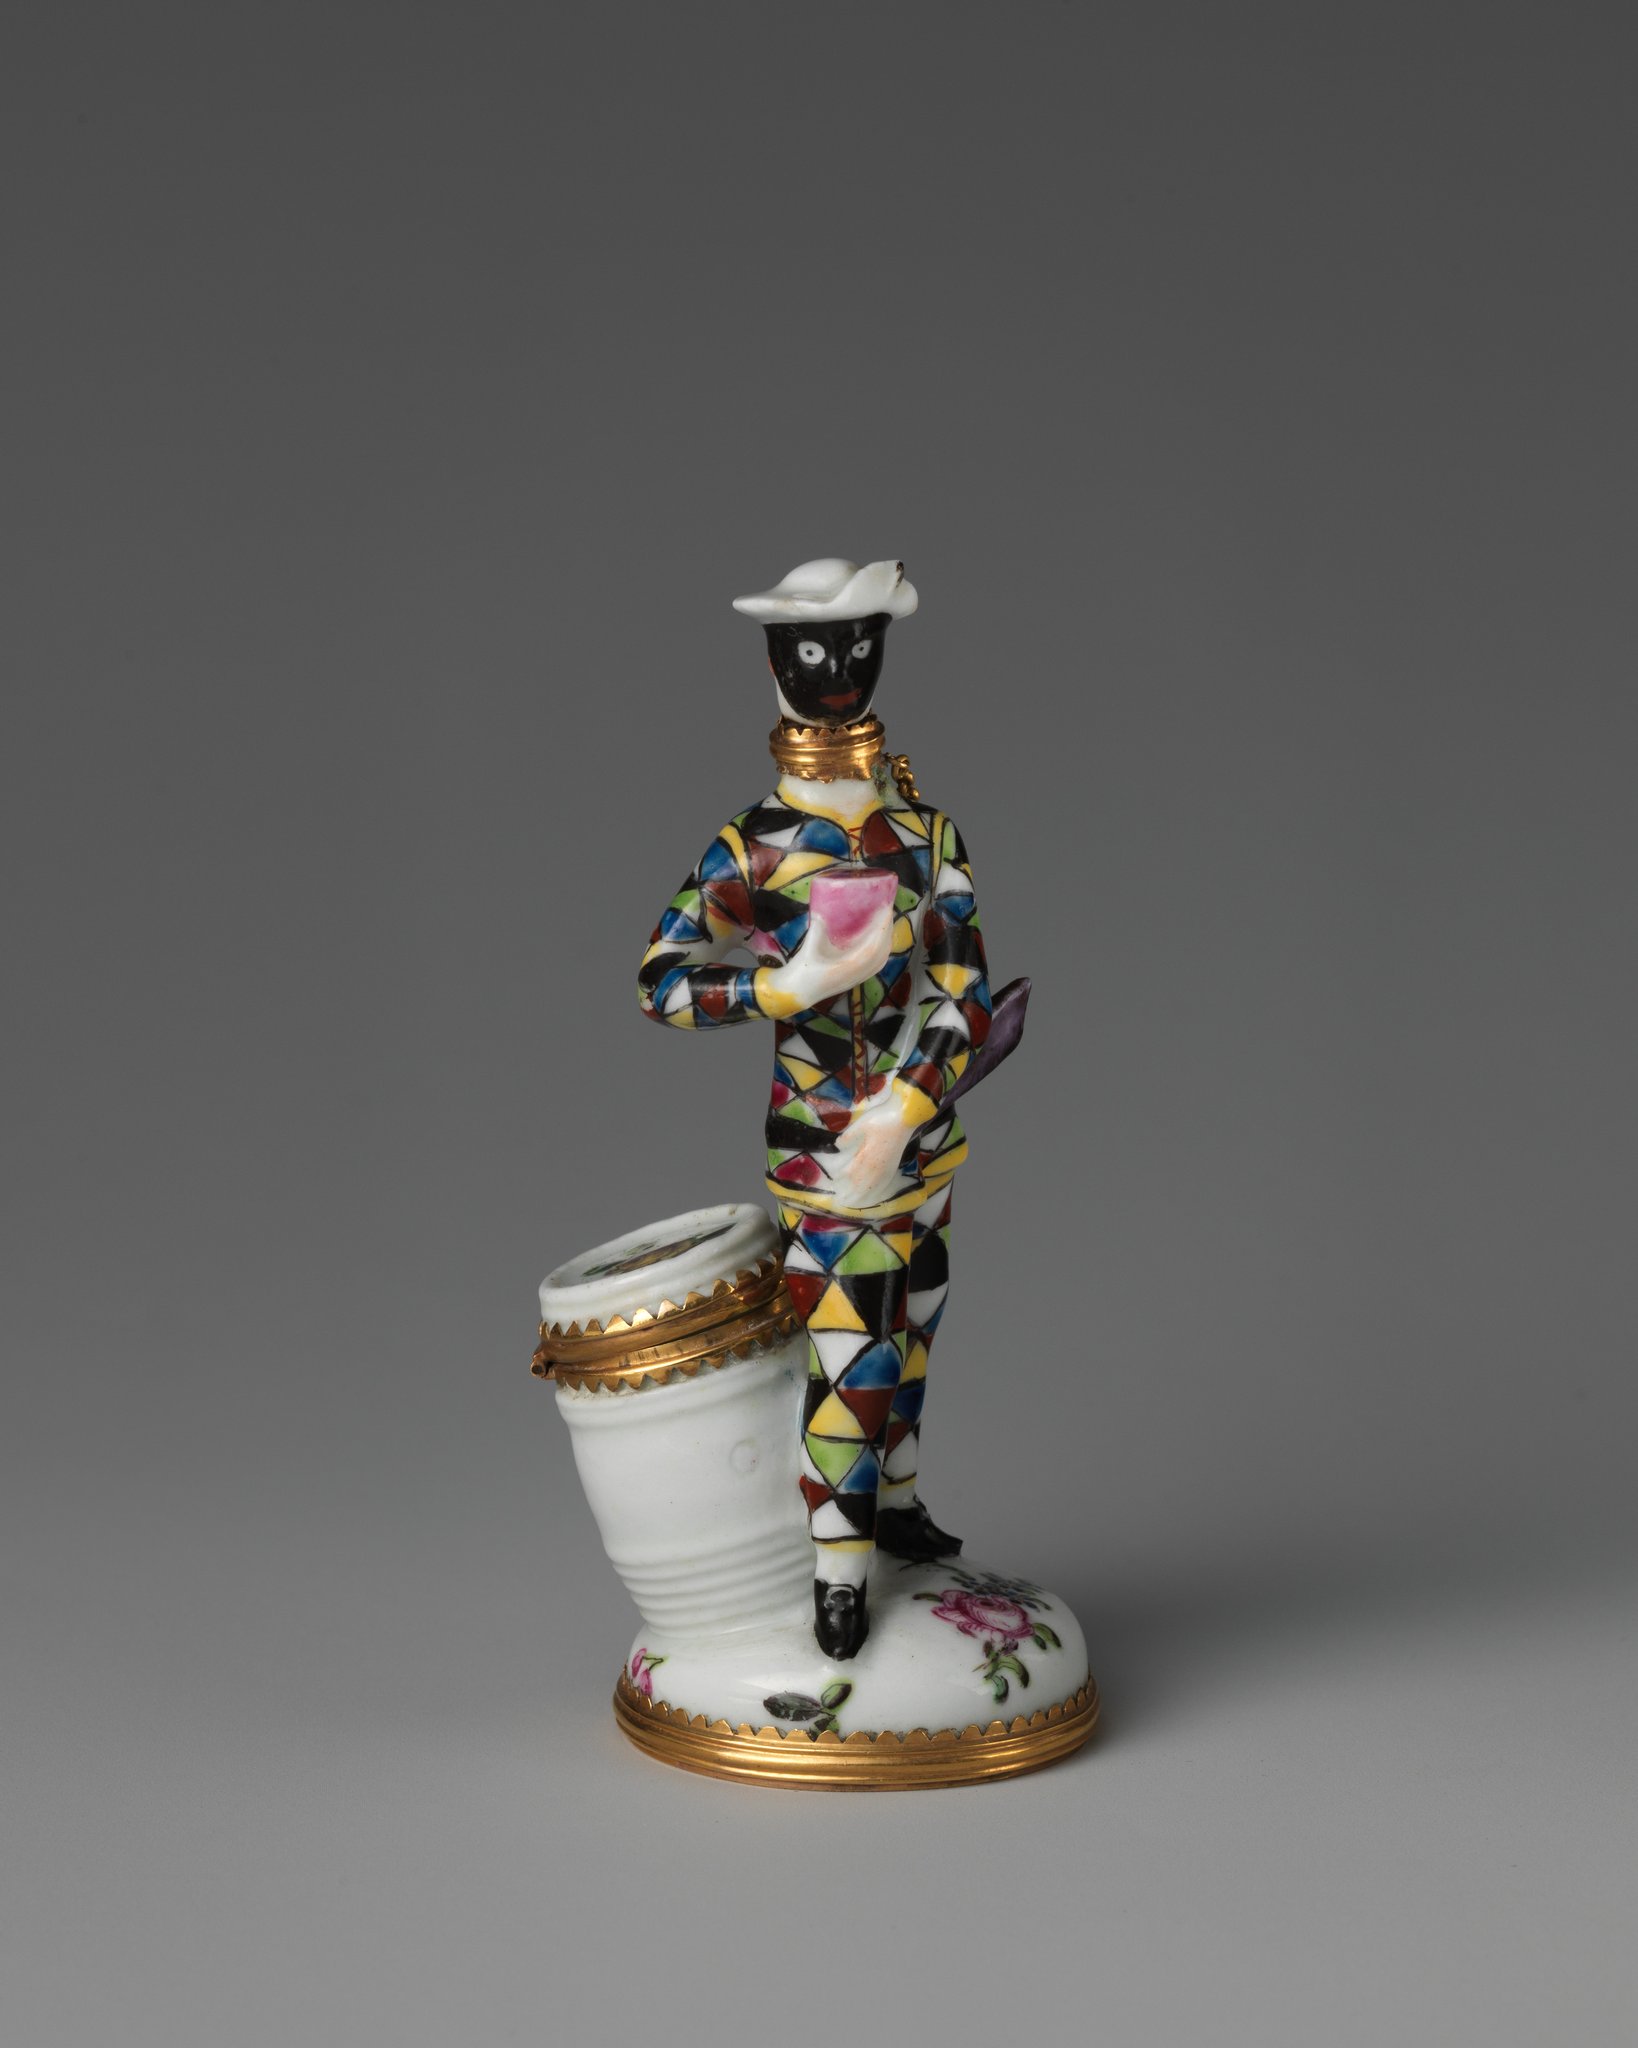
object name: toy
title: Harlequin with barrel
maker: saint james's factory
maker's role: maker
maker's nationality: british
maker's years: 1749-1759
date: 1755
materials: soft paste porcelain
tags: men